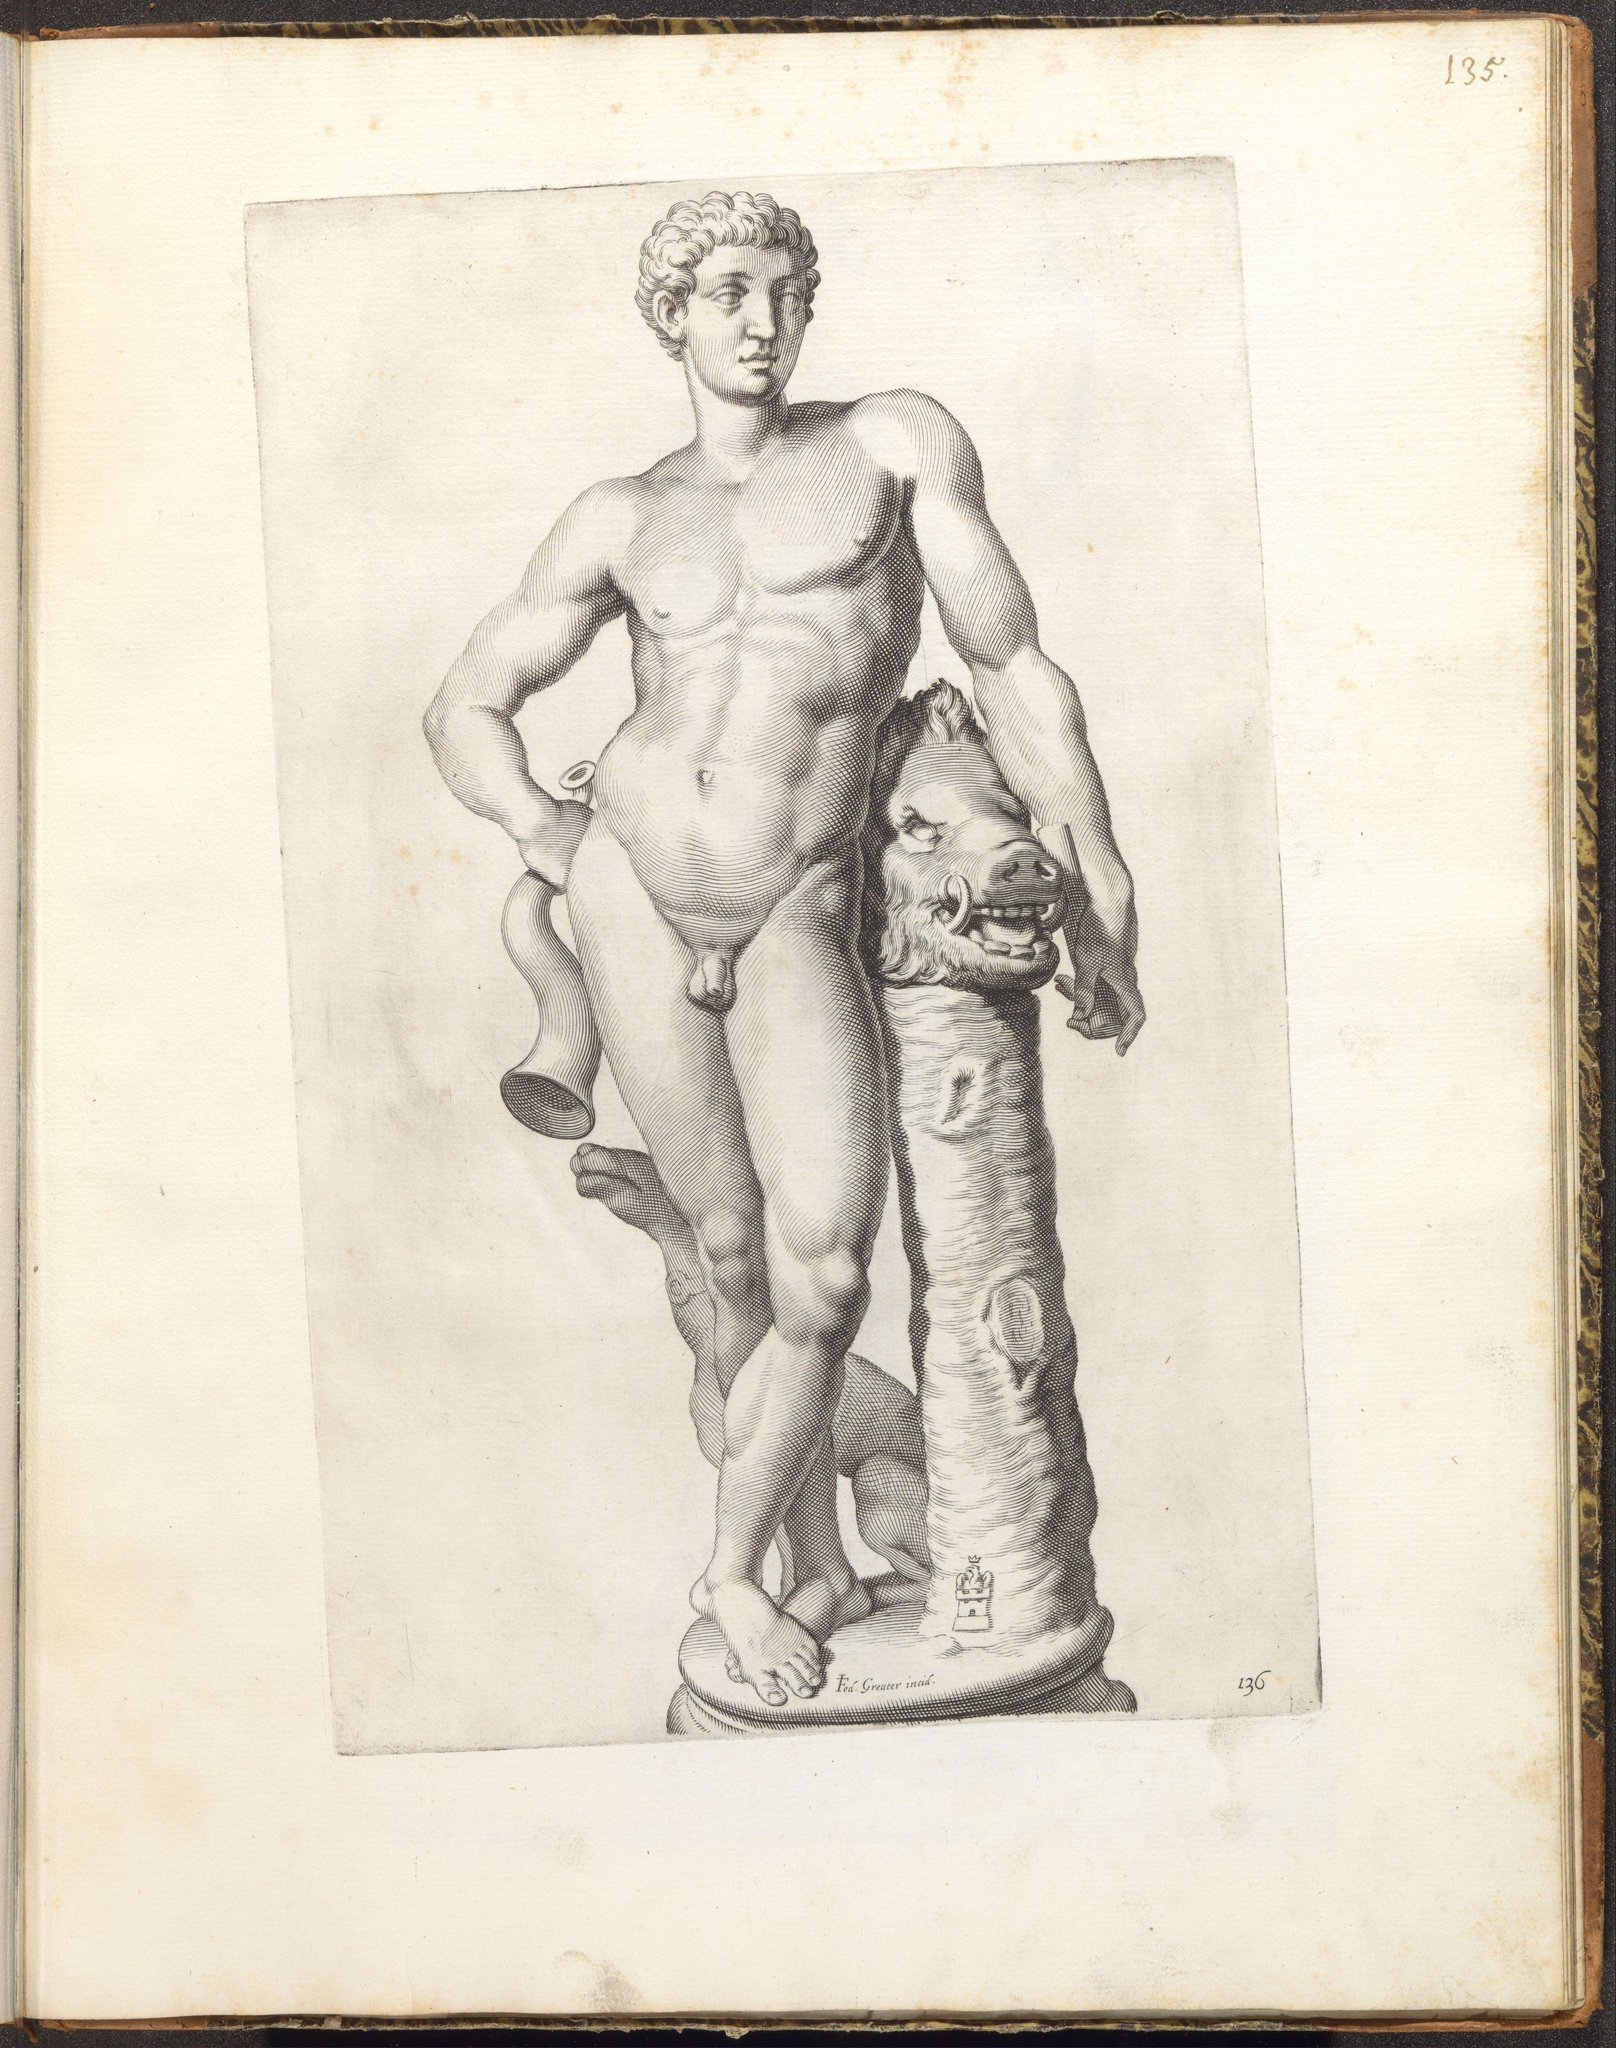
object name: print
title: Standbeeld van Meleager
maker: johann friedrich greuter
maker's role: print maker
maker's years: 1589-1662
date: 1636-1647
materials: paper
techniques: engraving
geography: rome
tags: piece of sculpture, reproduction of a piece of sculpture, (story of) meleager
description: Standbeeld van Meleager met jachthoorn in de hand naast de kop van het Caledonische zwijn. Naast hem een jachthond. Onderaan op de boomstam het wapenschild van Vincenzo Giustiniani. Prent maakt deel uit van een album met een serie prenten naar de sculpturen in de verzameling in de Galleria Giustiniani te Rome.